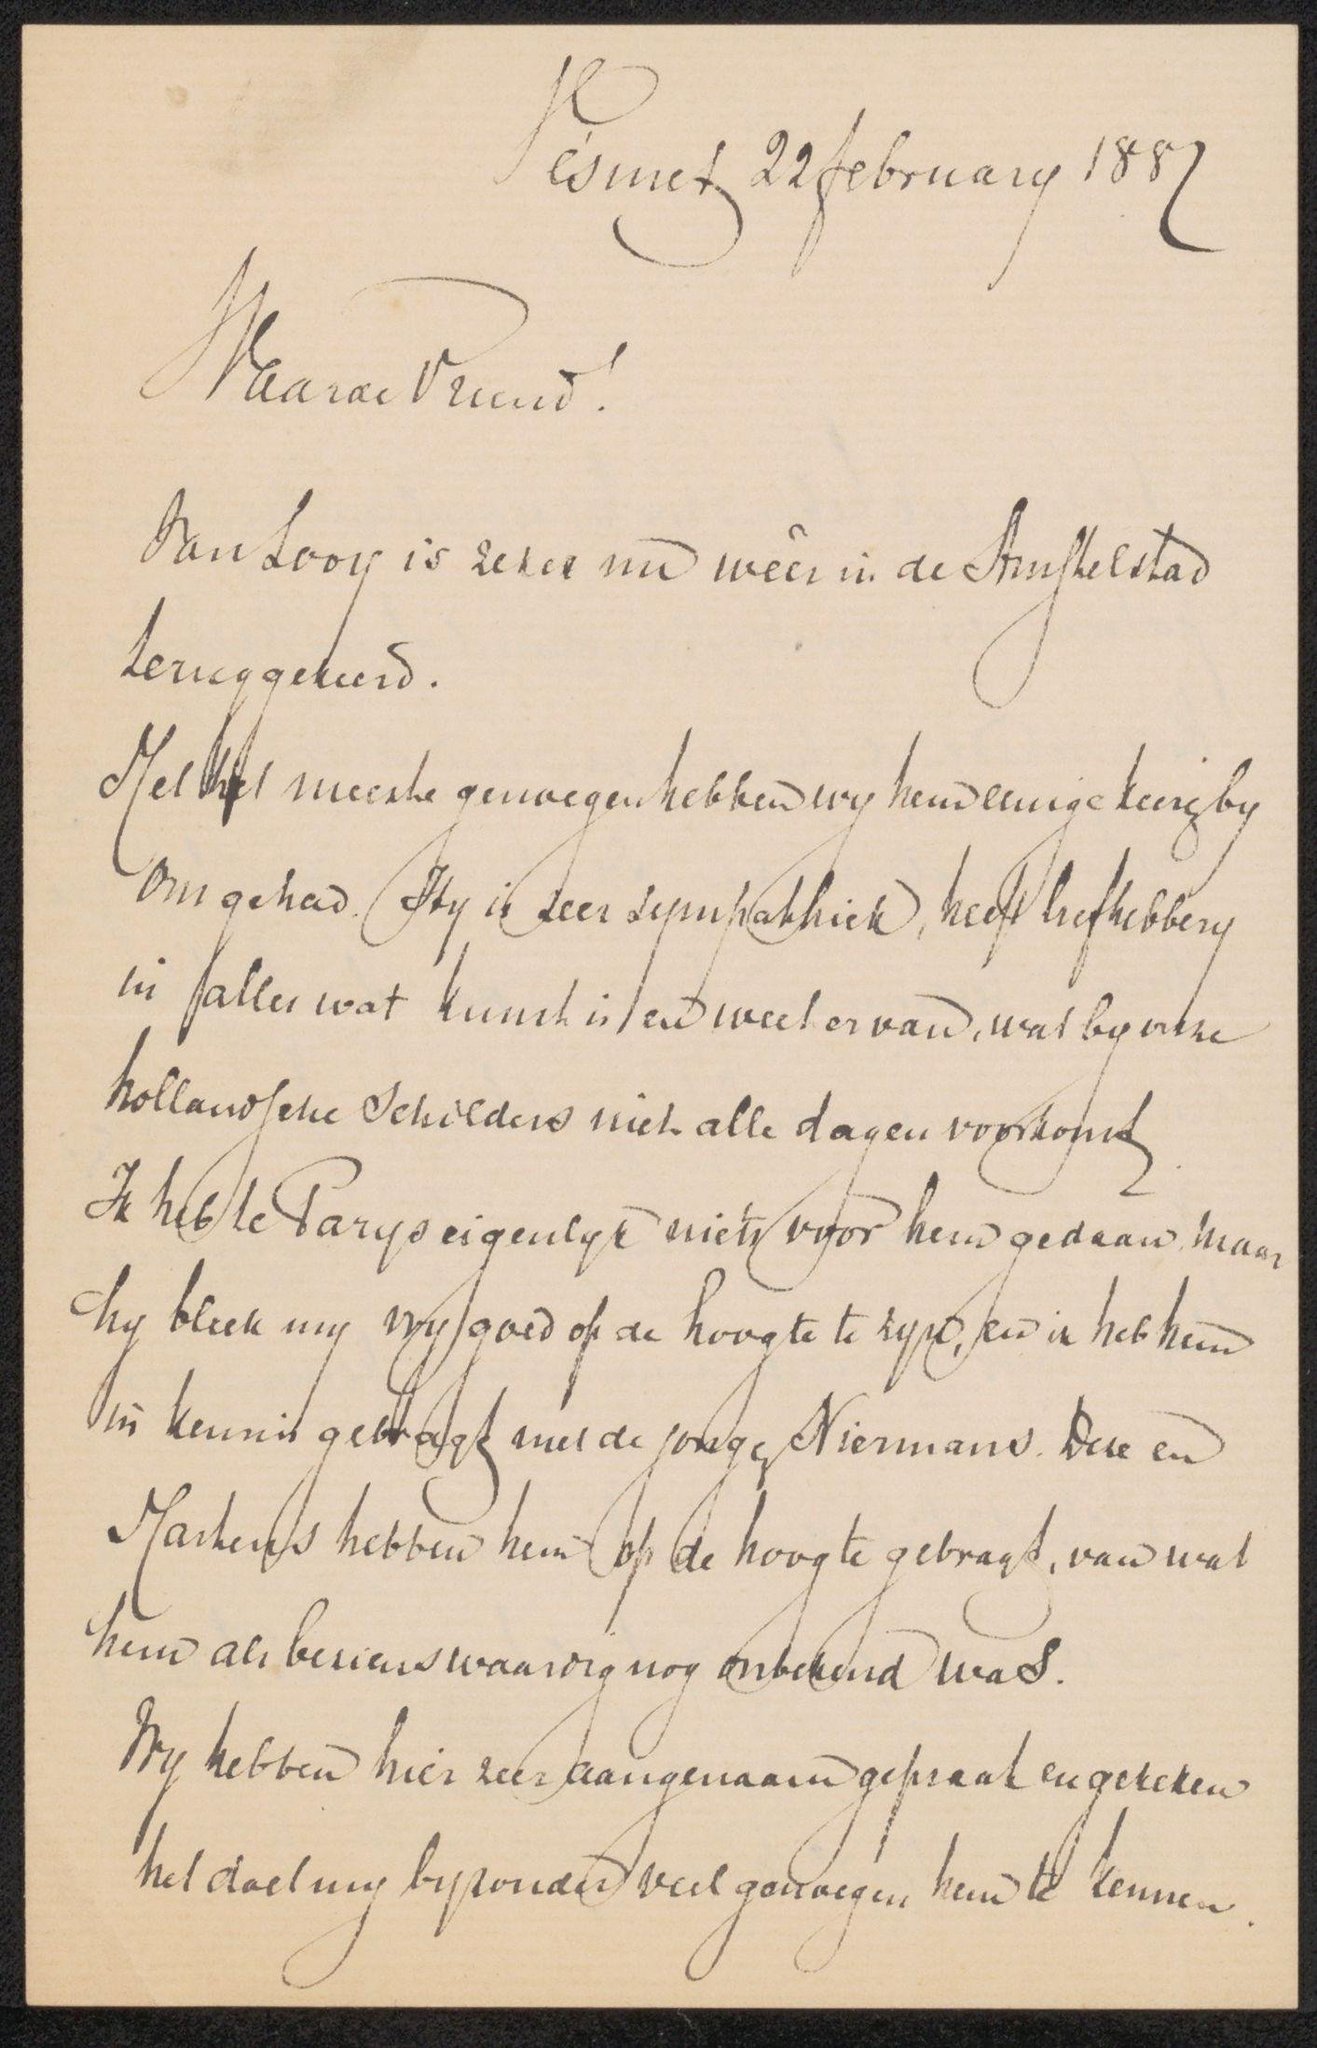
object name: letter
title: Brief aan August Allebé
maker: daniël franken dzn.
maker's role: bankier, kunsthistoricus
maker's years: 1838-1898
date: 1887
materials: ink, paper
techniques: pen, writing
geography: le vésinet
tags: adolphe mouilleron, amsterdam, print maker, draughtsman, august allebé, brussels, paris, alfred stevens, the hague, painter, willy martens, charles comte, haarlem, jac van looij, eduard niermans, drawing, the graphic arts, painting (including book-illumination, miniature-painting)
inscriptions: watermark